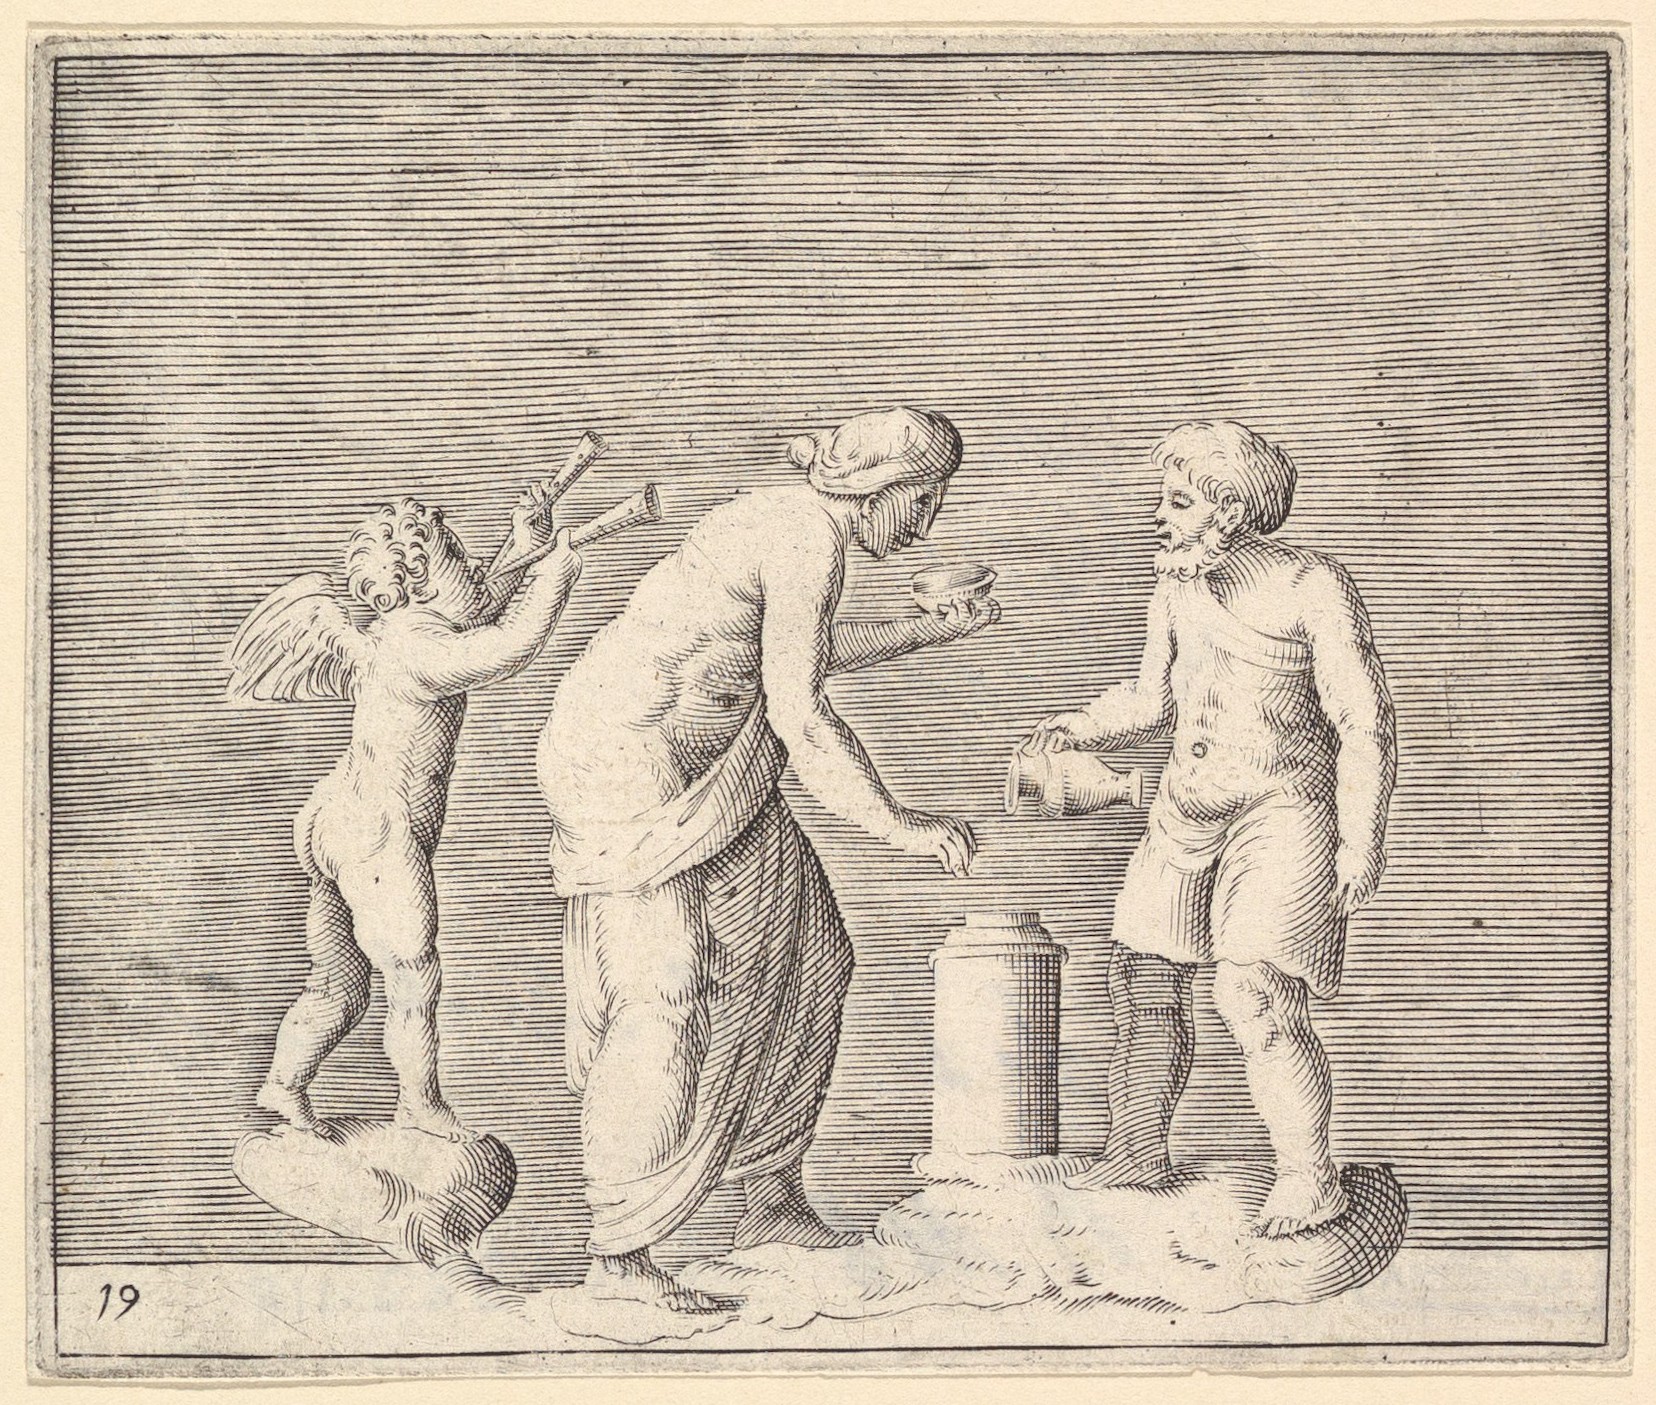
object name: print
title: A Woman and Man Sacrificing in the Presence of Cupid, from "Ex Antiquis Cameorum et Gemmae Delineata/ Liber Secundus/et ab Enea Vico Parmen Incis"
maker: anonymous, italian, 16th century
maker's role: artist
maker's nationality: italian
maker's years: 1500-1600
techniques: engraving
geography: rome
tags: men,women,cupid